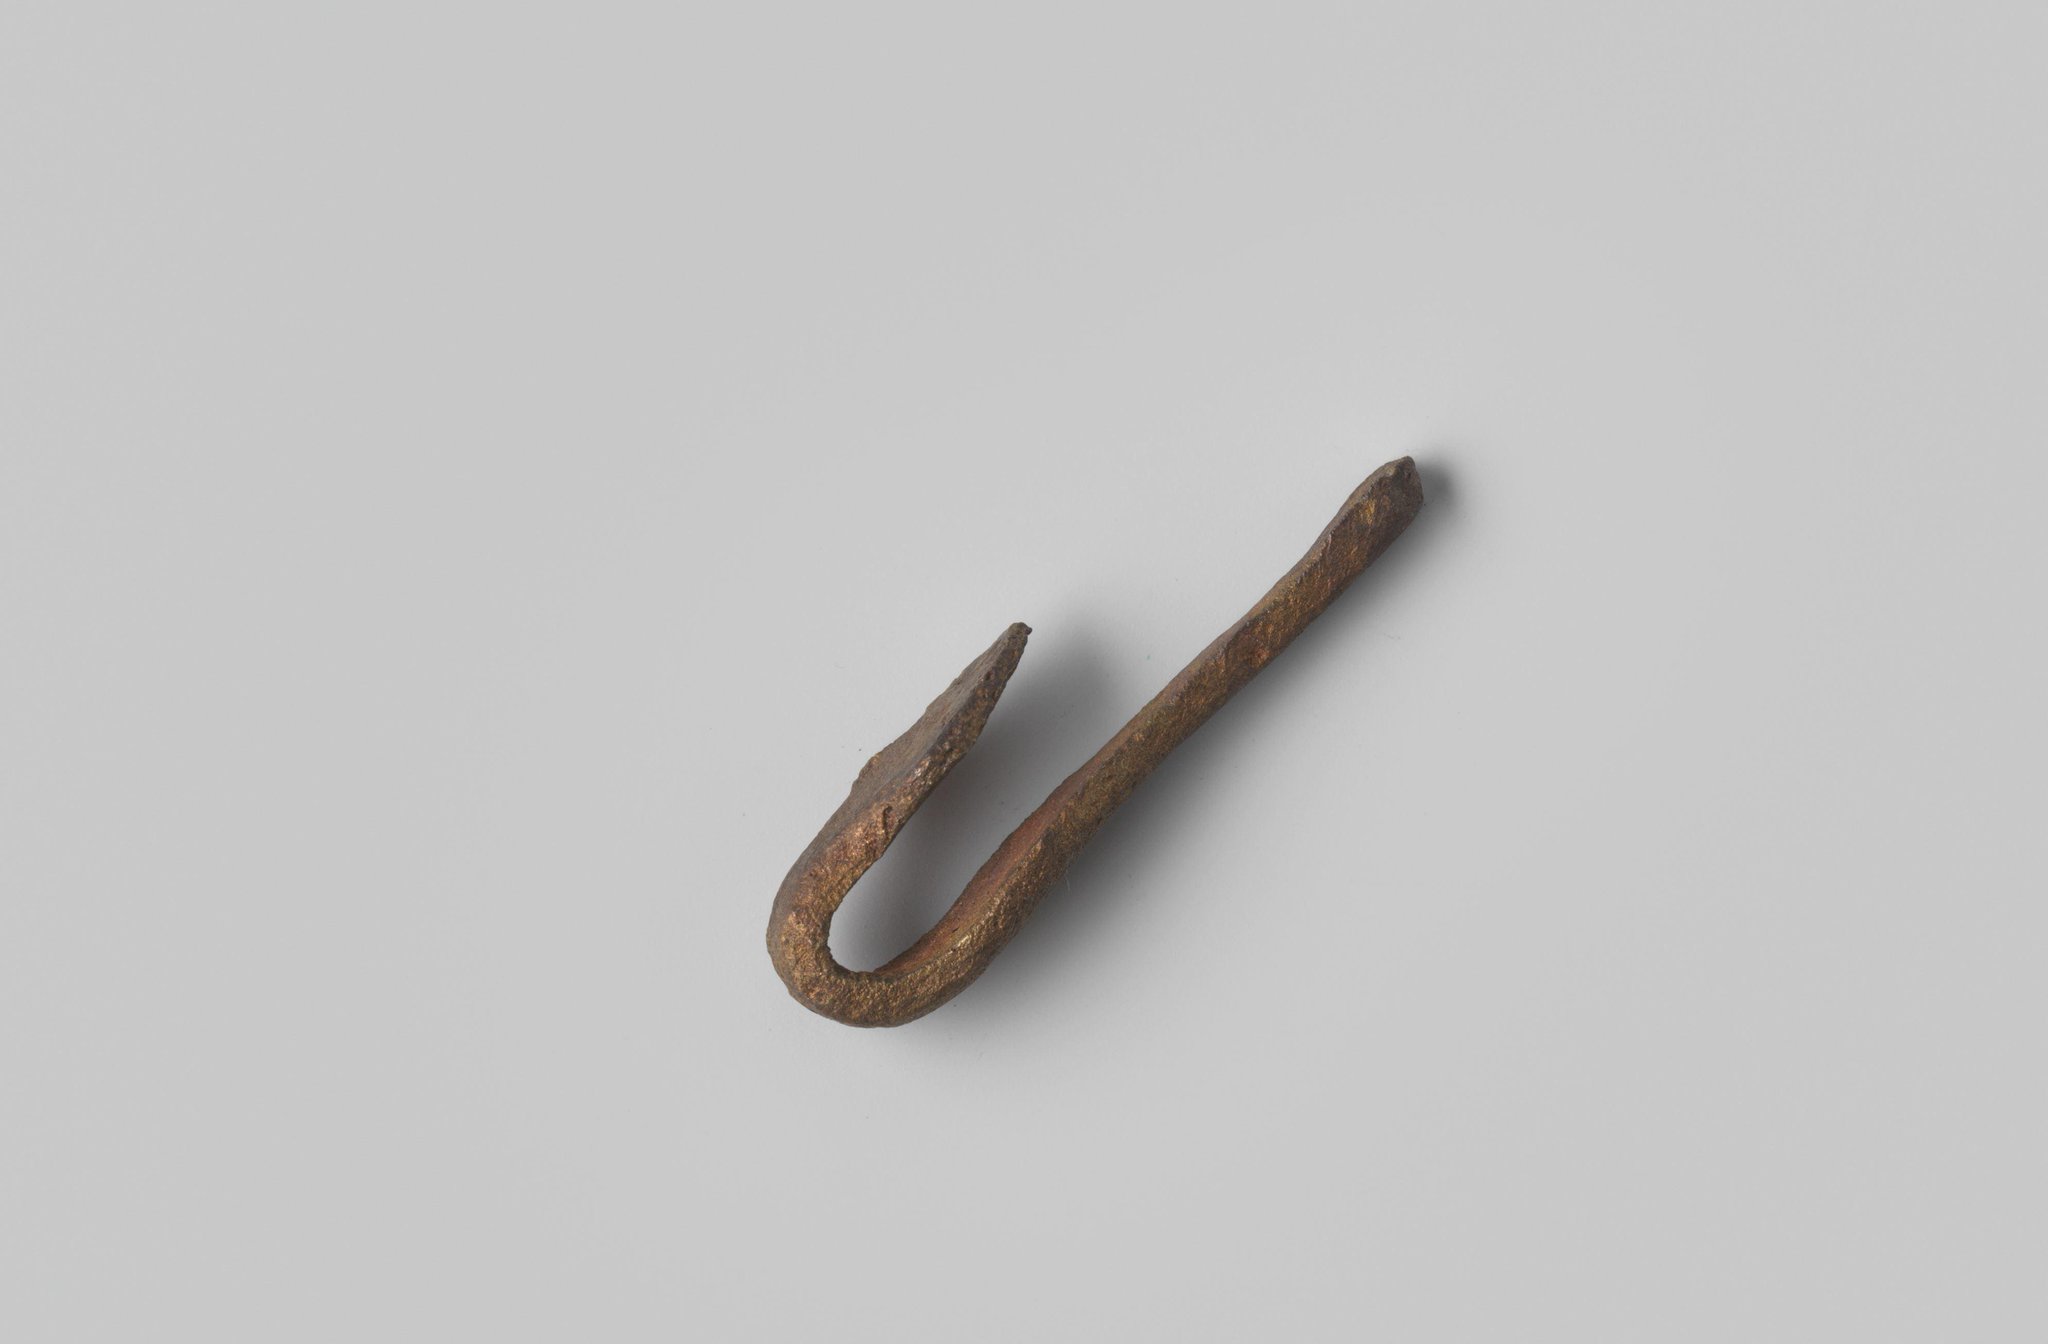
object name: clip bevestigingsmiddel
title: Clip van schede uit het wrak van de Oost-Indiëvaarder Hollandia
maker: Anonymous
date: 1700-1743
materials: copper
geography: netherlands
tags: verenigde oostindische compagnie, hollandia (schip), annet